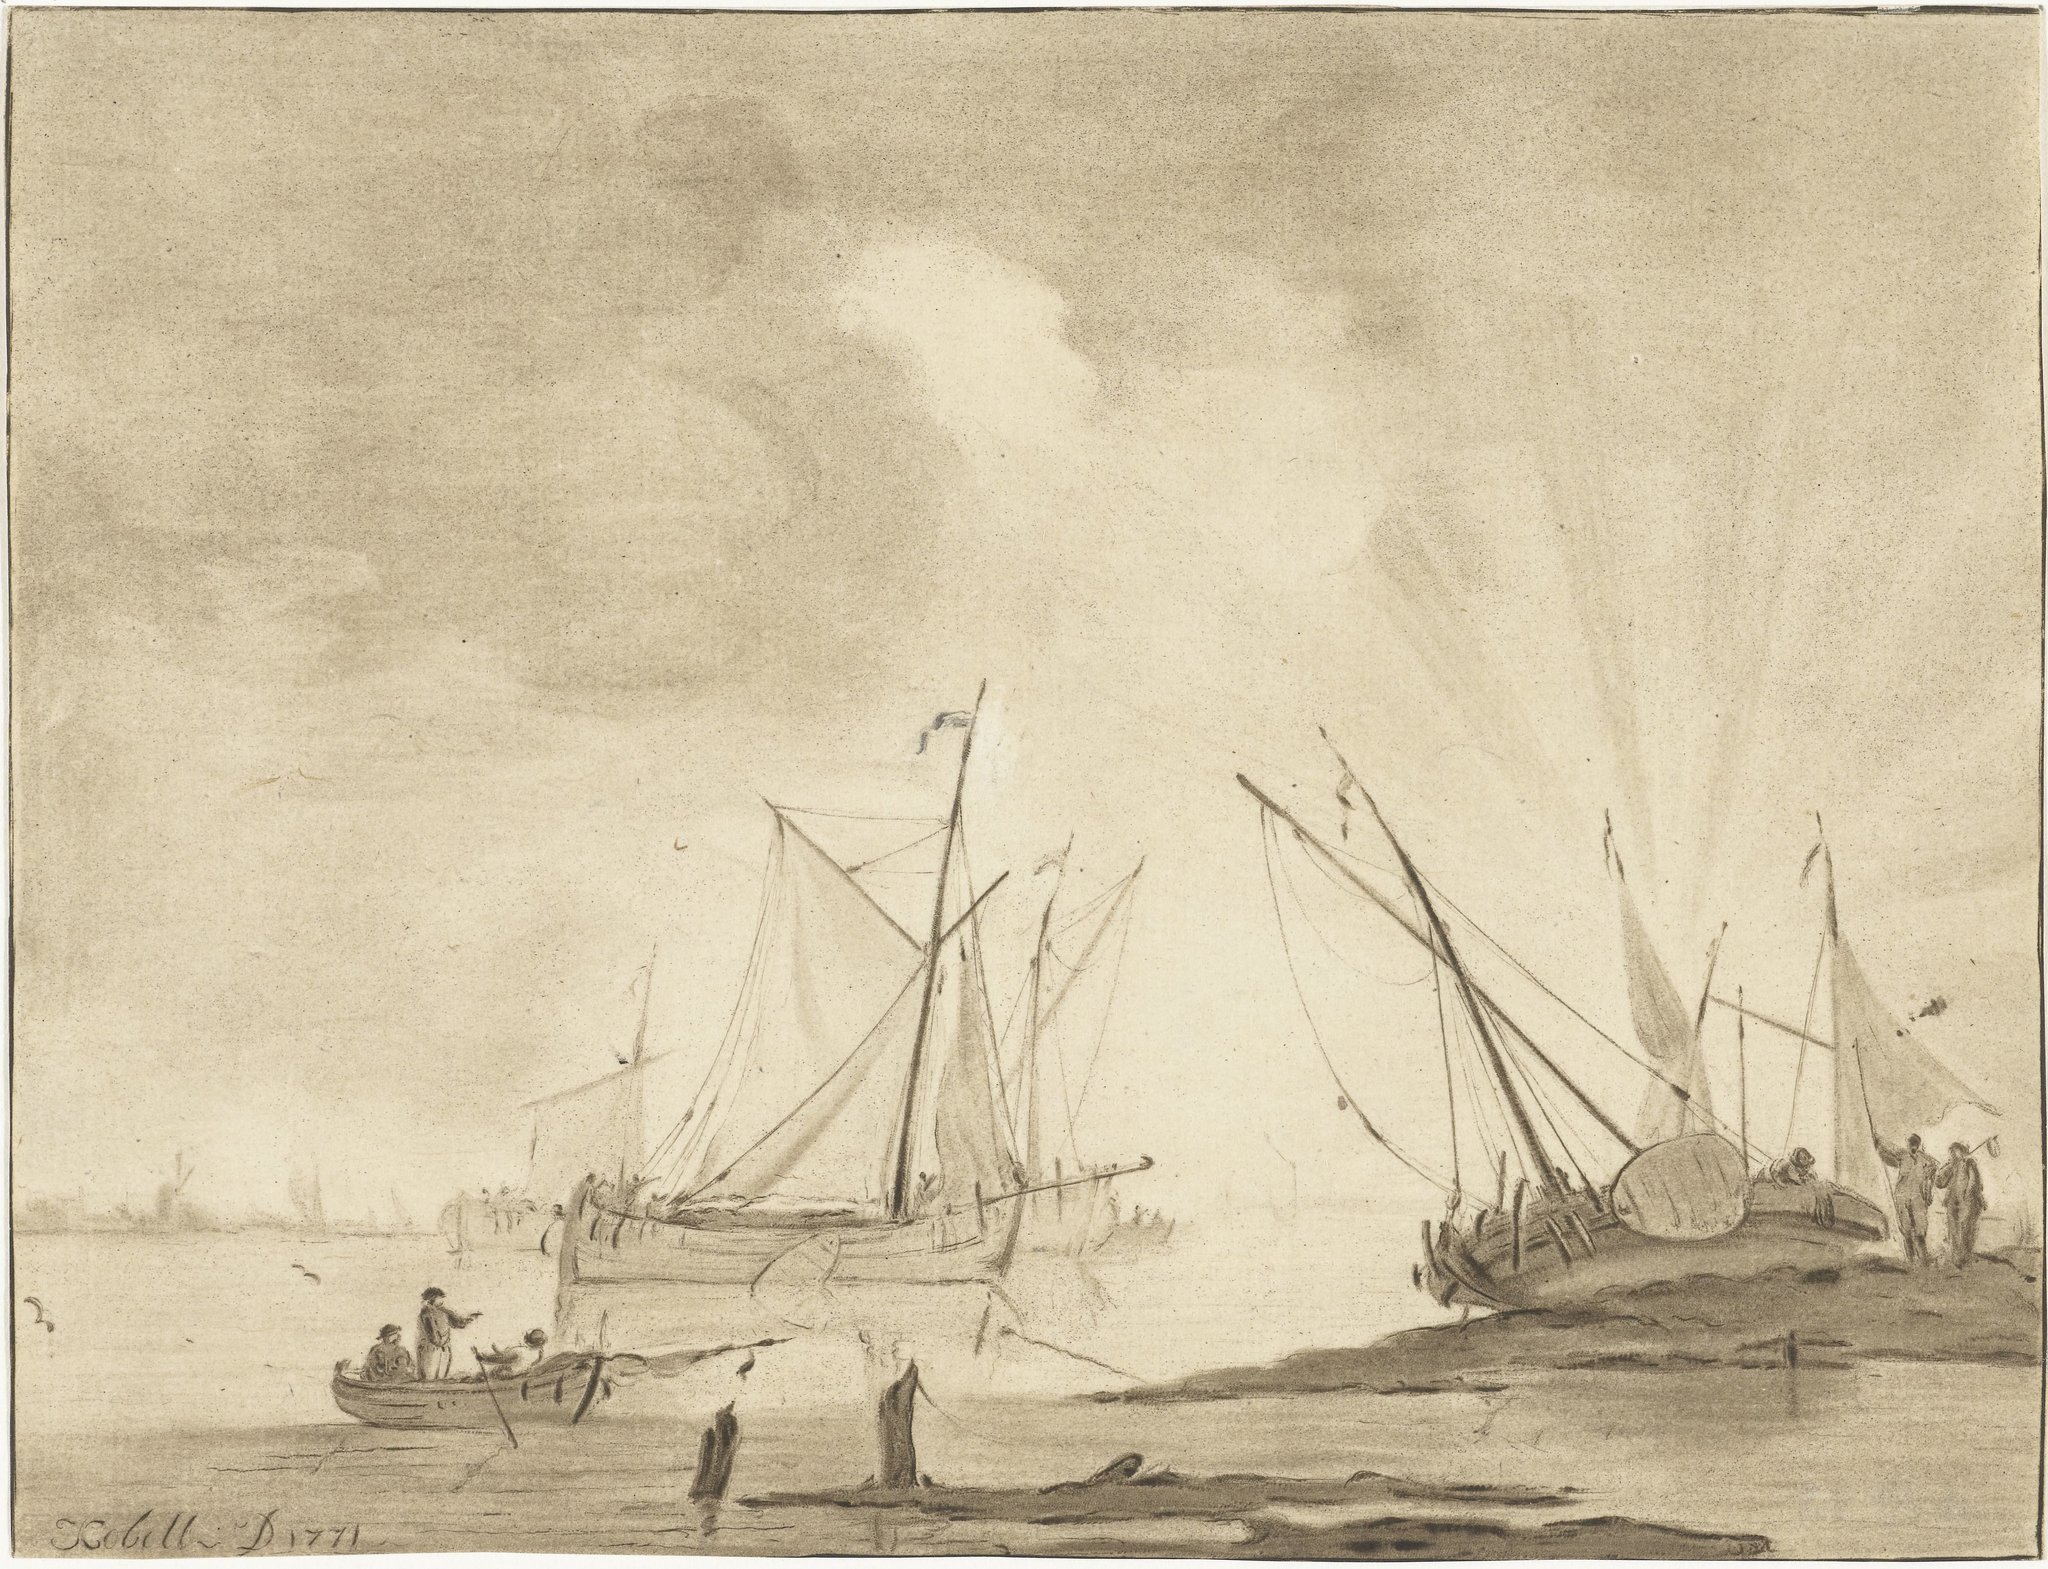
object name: print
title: Rivierlandschap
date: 1771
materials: paper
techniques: print drawing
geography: amsterdam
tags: river (+ landscape with figures, staffage), river bank (+ landscape with figures, staffage)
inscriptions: collector's mark: Lugt 2228